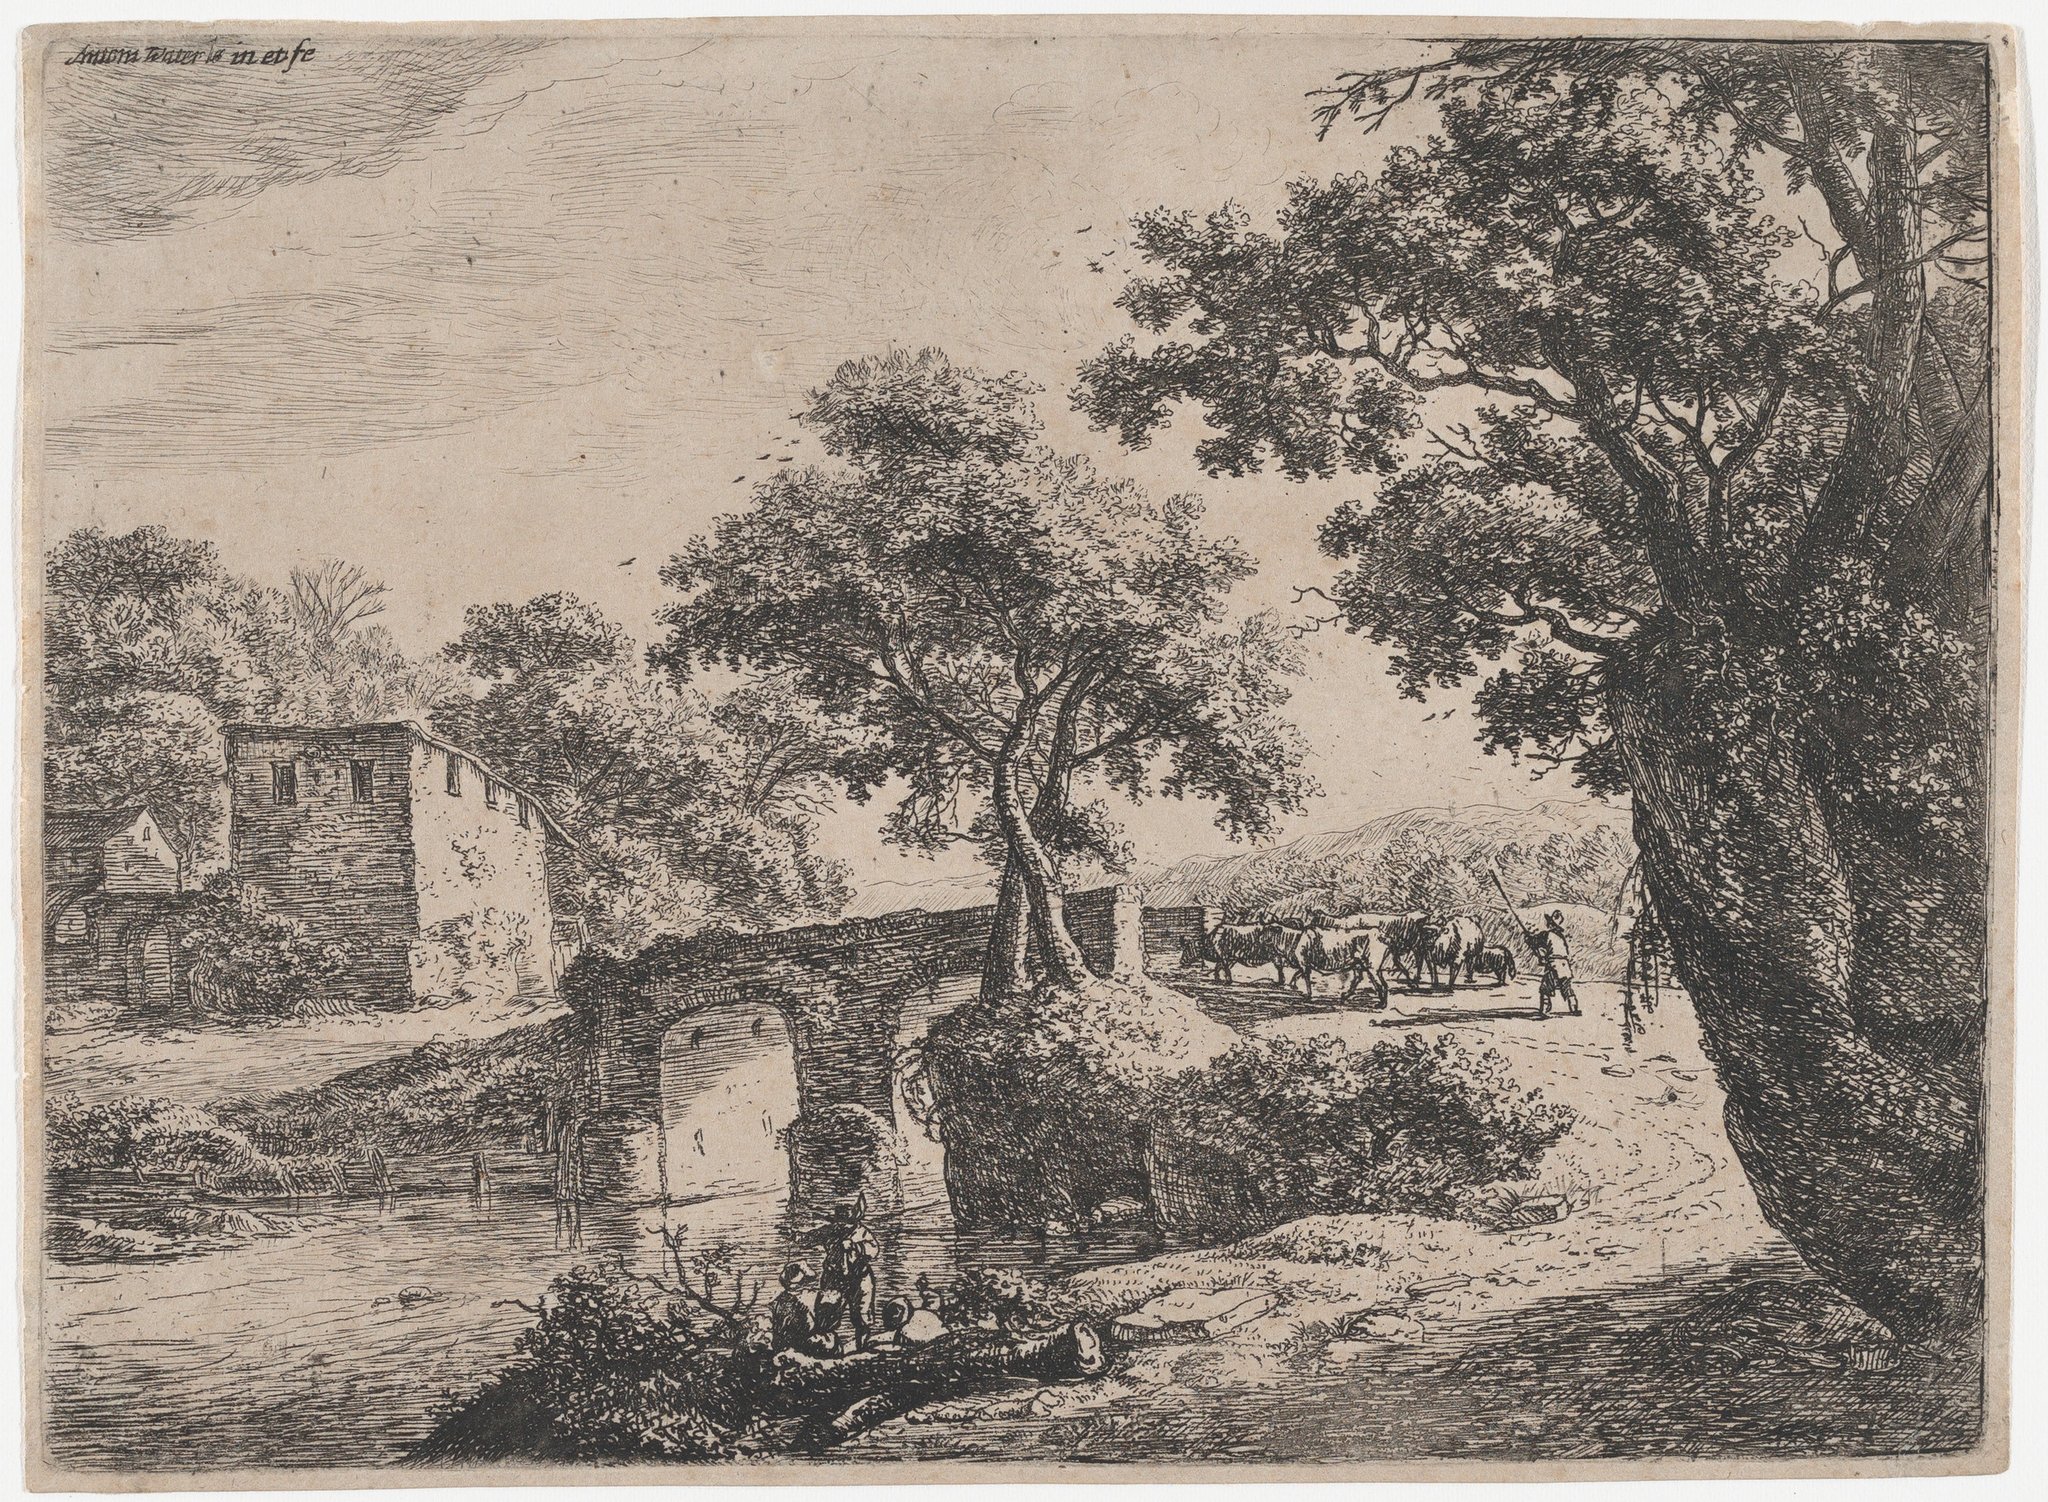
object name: print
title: Herd Near a Stone Bridge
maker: anthonie waterloo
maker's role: artist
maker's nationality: dutch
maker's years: 1609-1690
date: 1601-1700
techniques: etching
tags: bridges,cows,landscapes